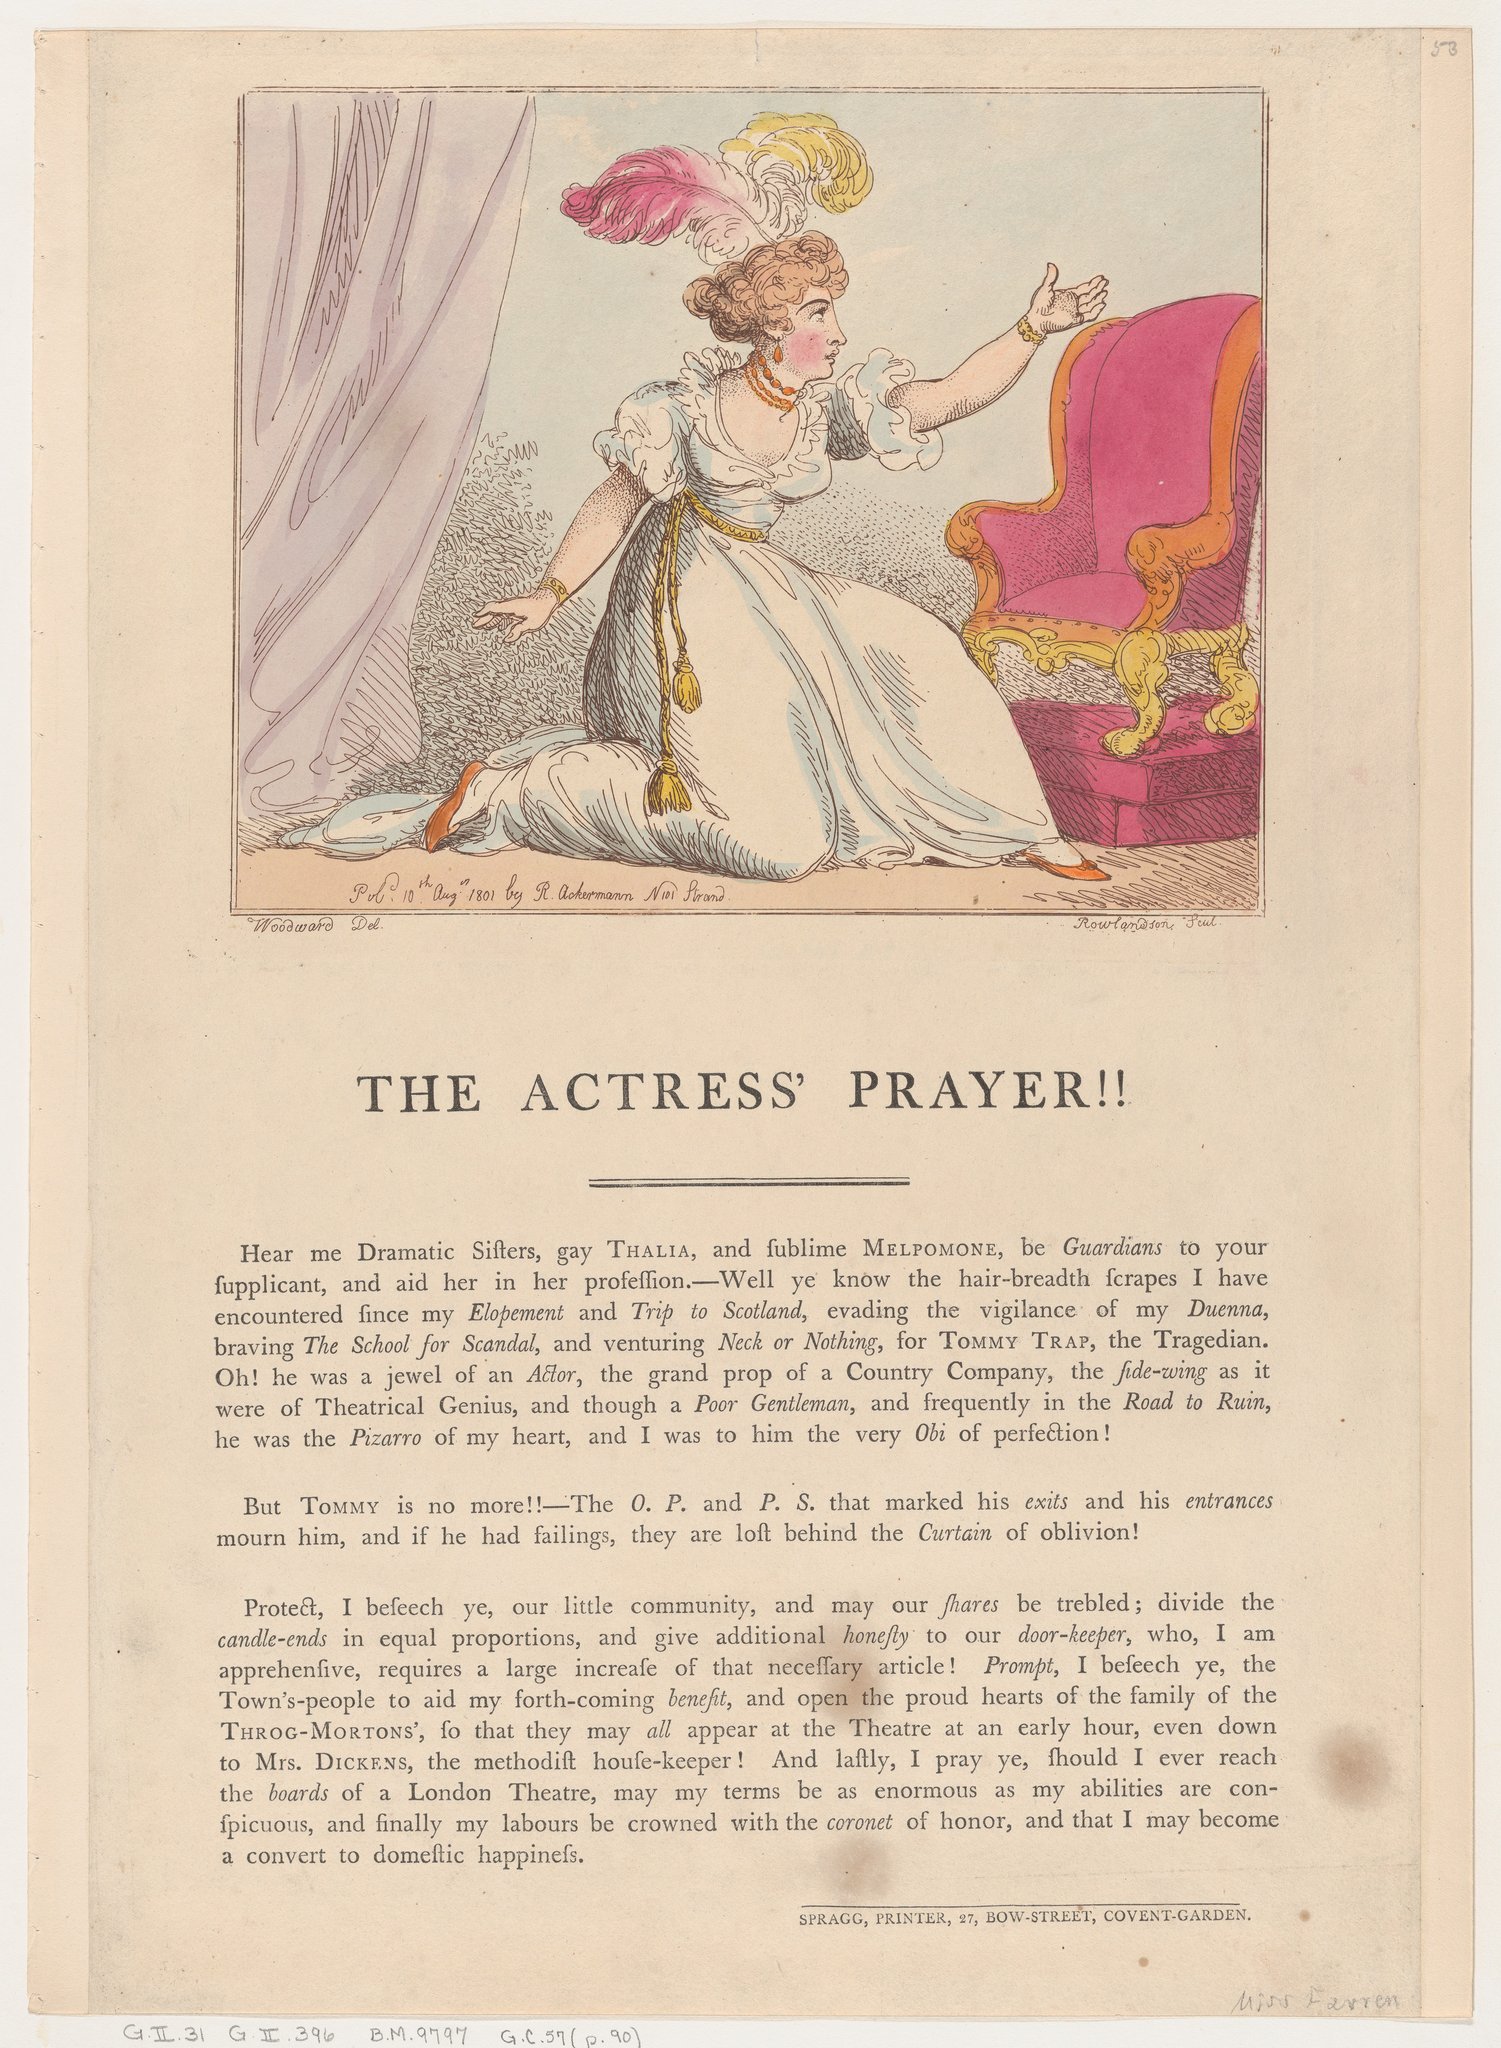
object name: print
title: The Actress' Prayer!!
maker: thomas rowlandson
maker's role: artist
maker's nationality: british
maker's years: 1757-1827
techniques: etching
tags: profiles,women,actresses